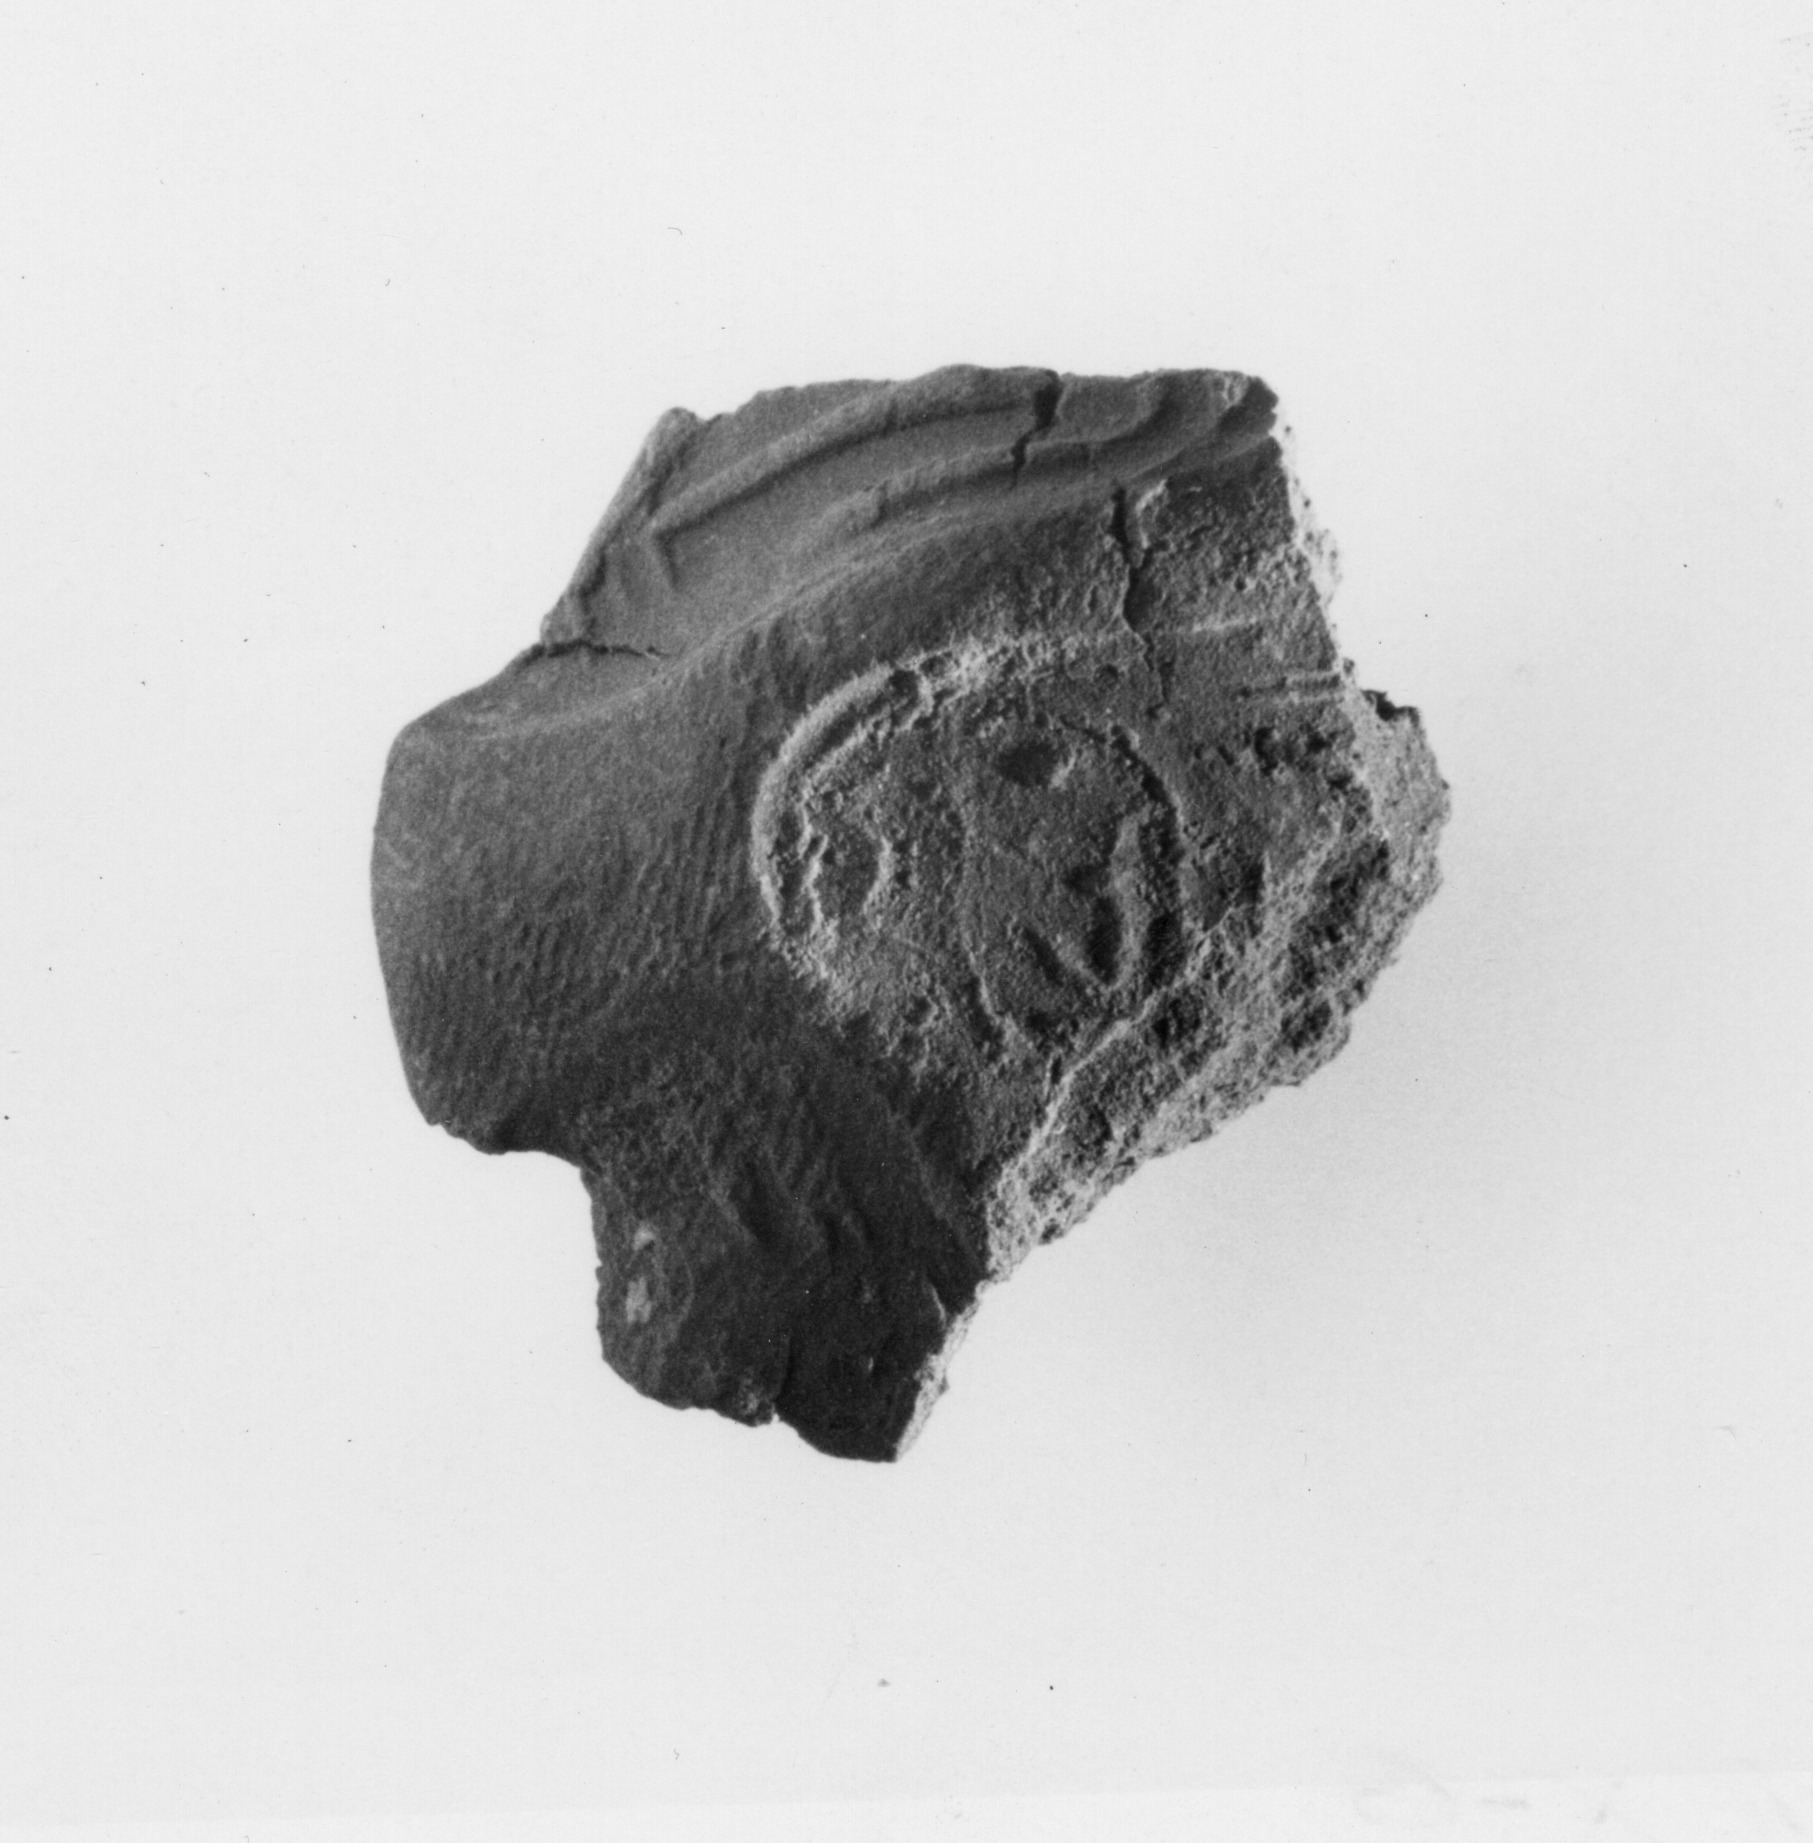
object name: sealing, nebmaatre, amenhotep iii, heb sed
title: Document Sealing With Multiple Seal Impressions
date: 1390-1352 BCE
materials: mud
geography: egypt